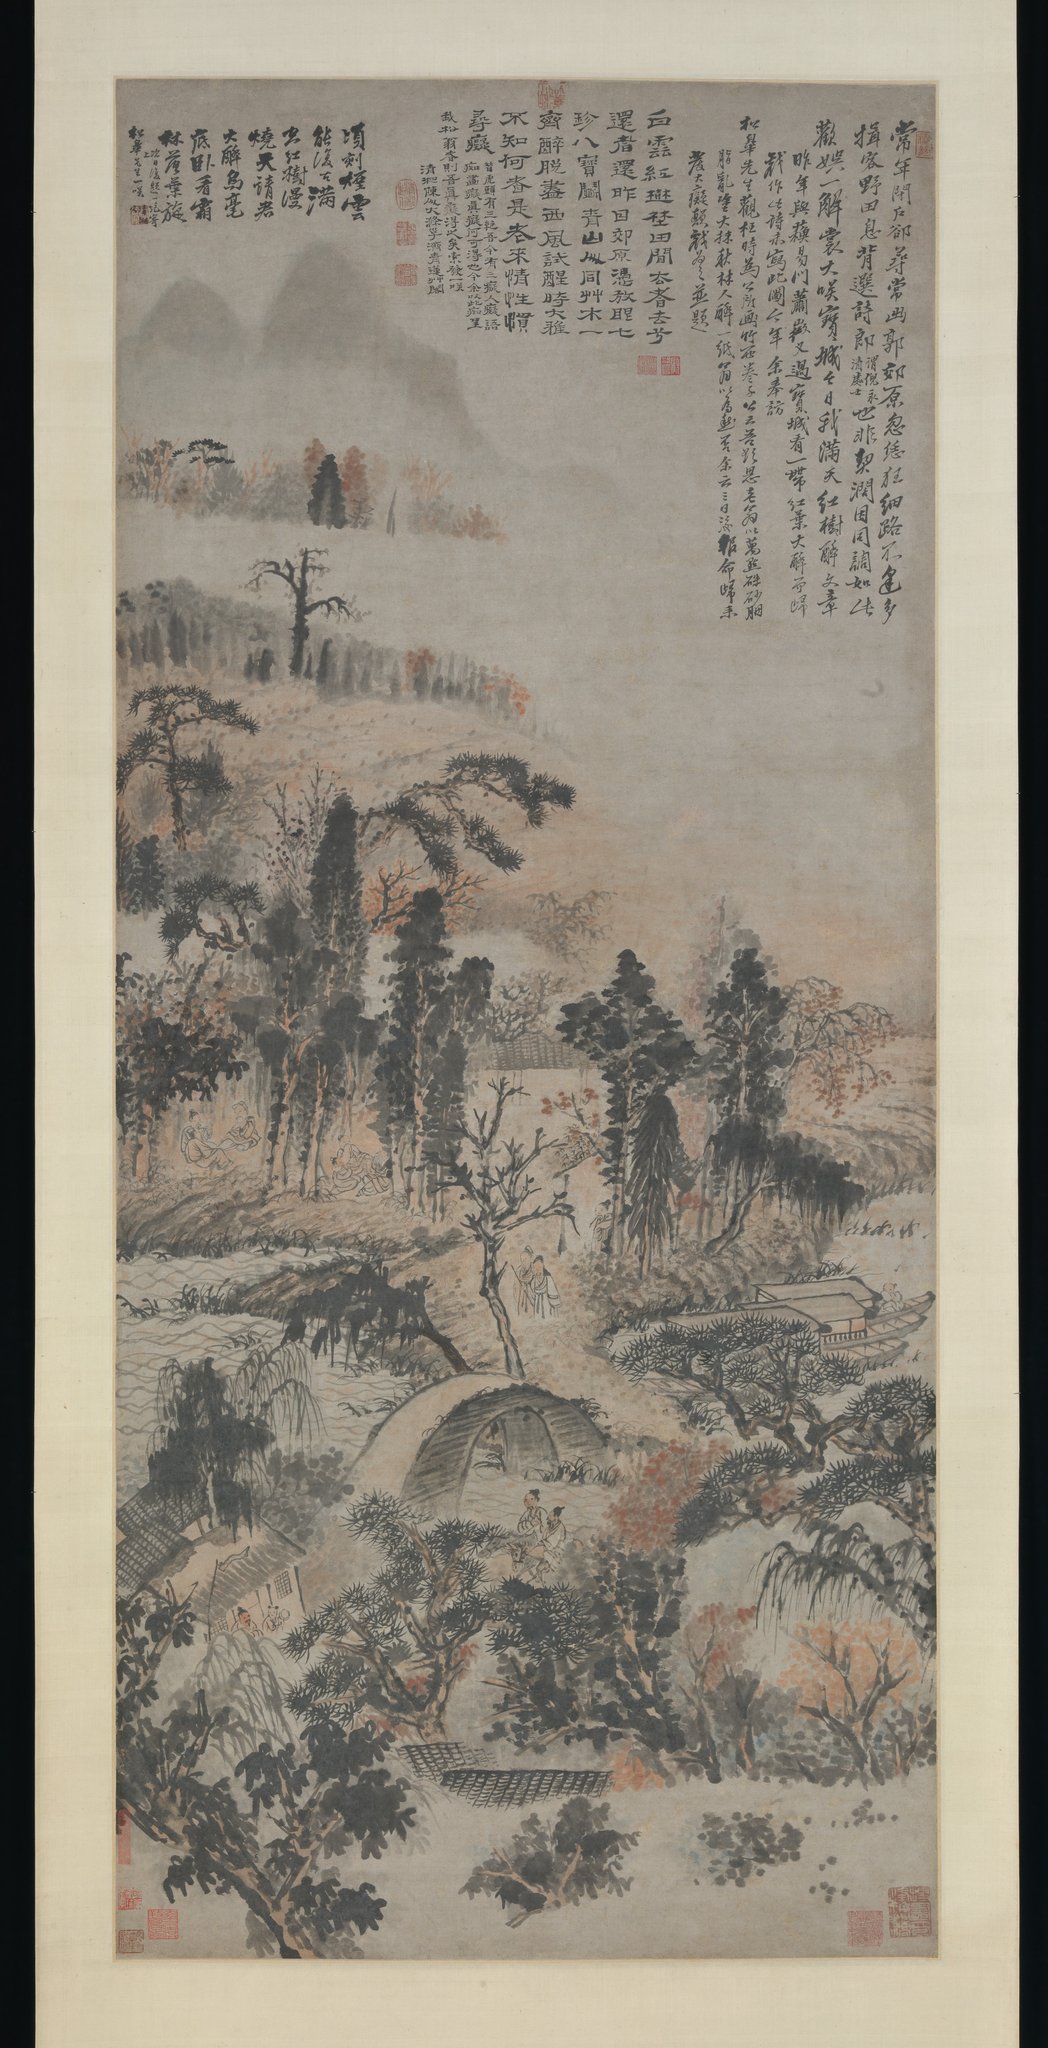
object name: hanging scroll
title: Drunk in Autumn Woods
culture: chinese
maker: shitao (zhu ruoji)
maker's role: artist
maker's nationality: chinese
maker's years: 1642-1707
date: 1702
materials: ink, paper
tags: landscapes